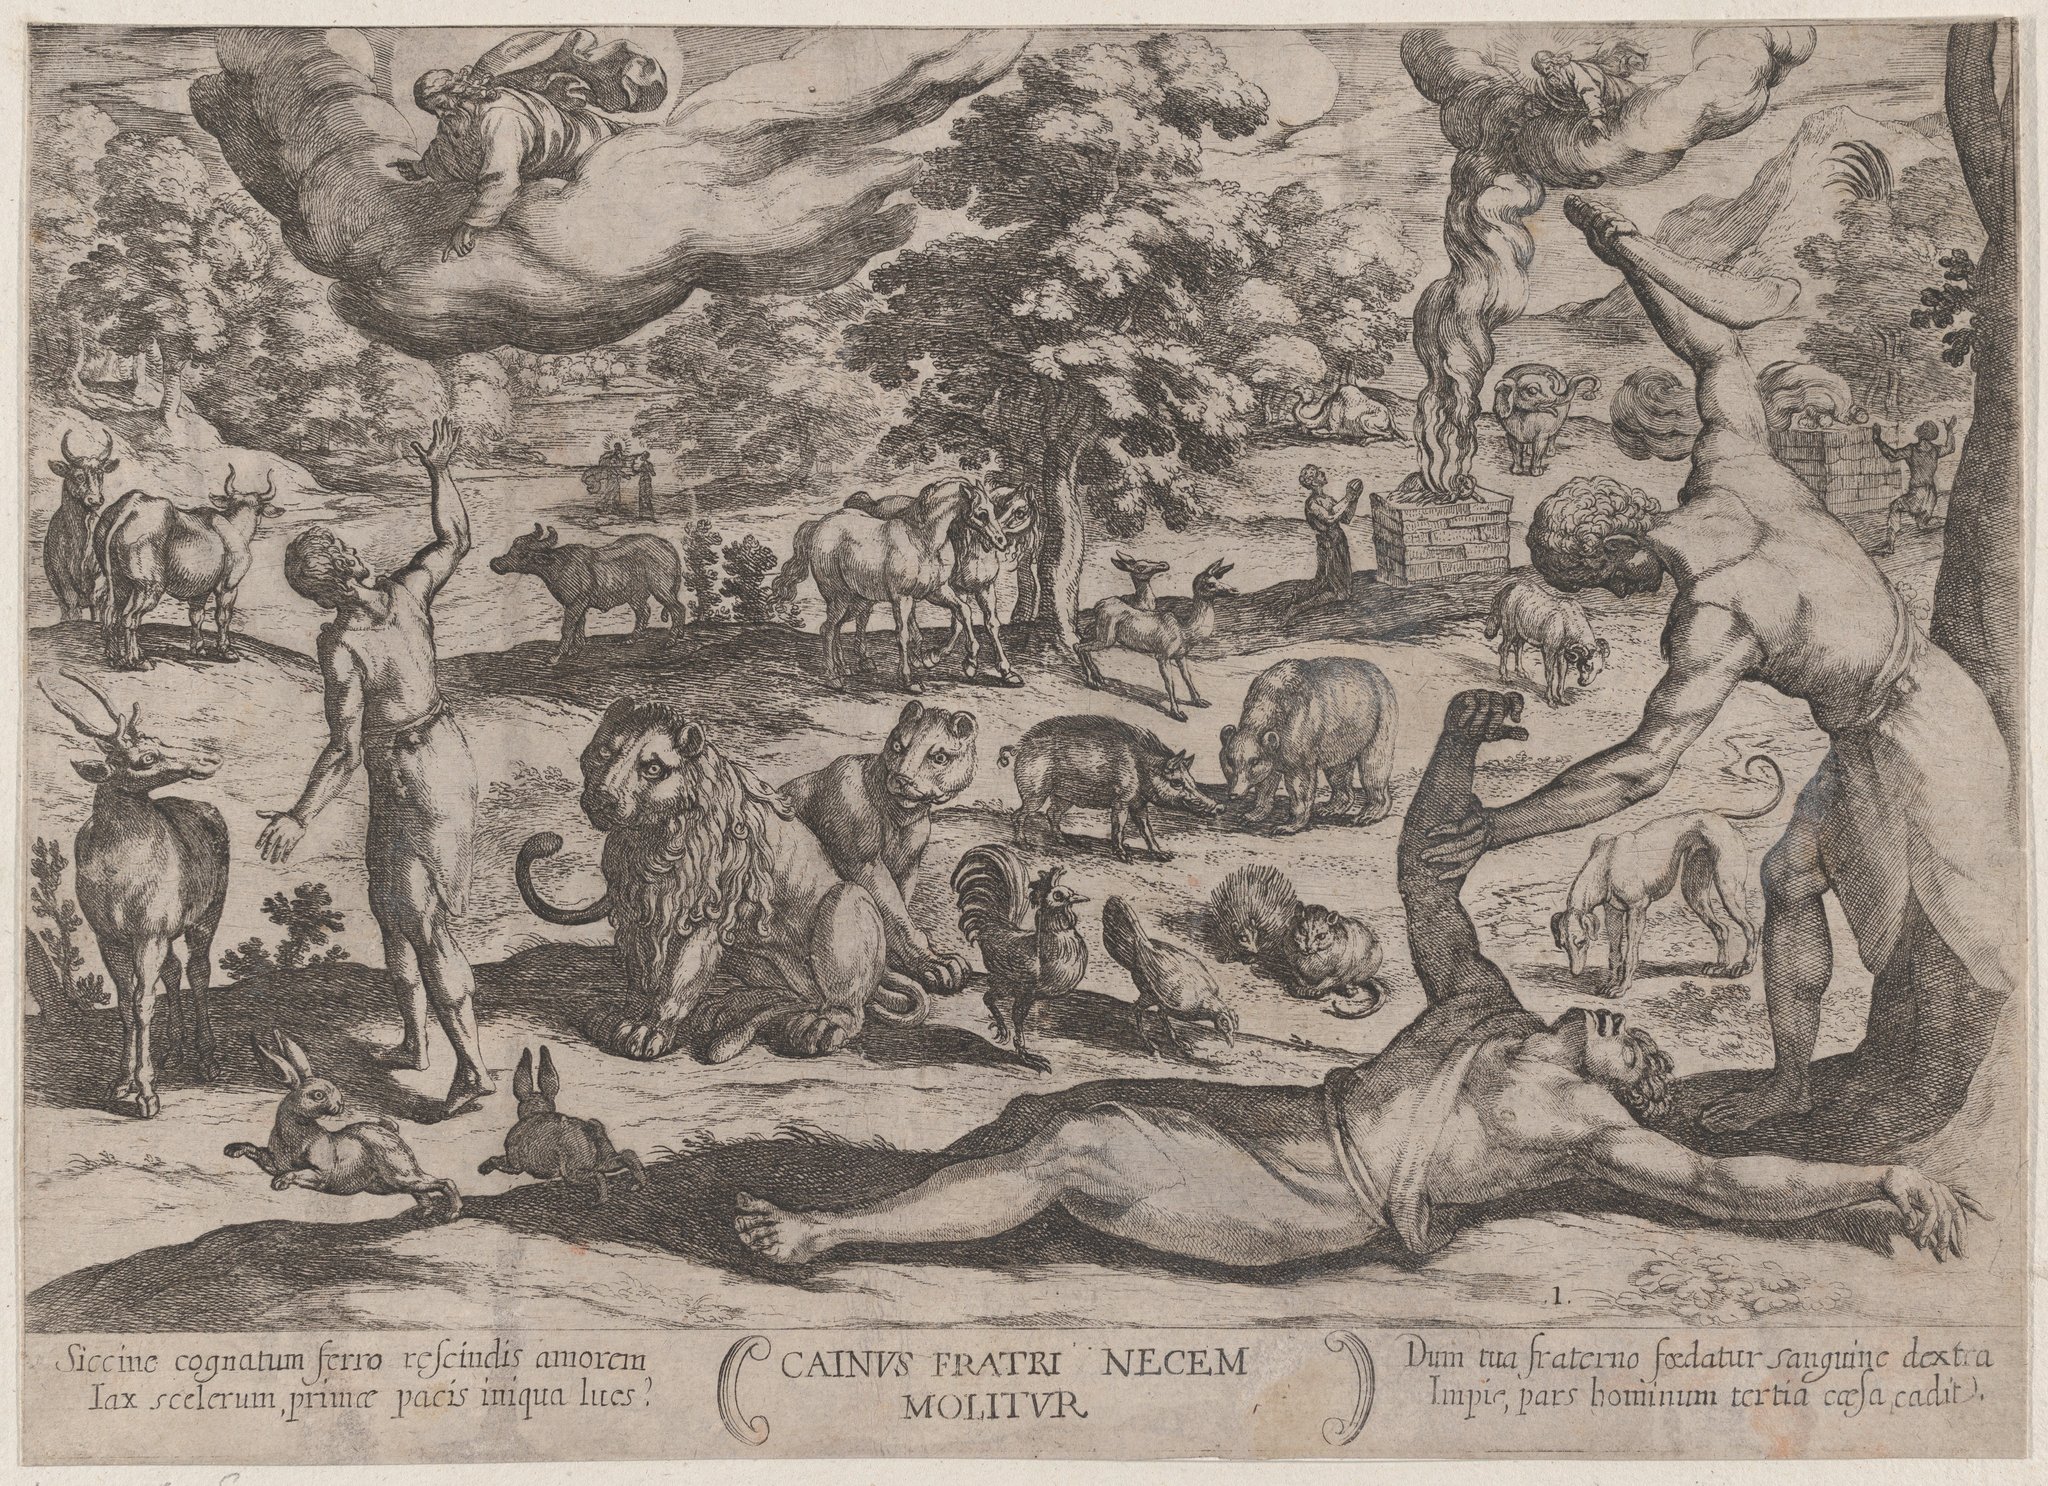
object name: print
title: Plate 1: Cain Killing Abel, from "The Battles of the Old Testament"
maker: antonio tempesta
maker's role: artist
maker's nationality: italian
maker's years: 1555-1630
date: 1590-1610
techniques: etching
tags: animals,abel,cain,death